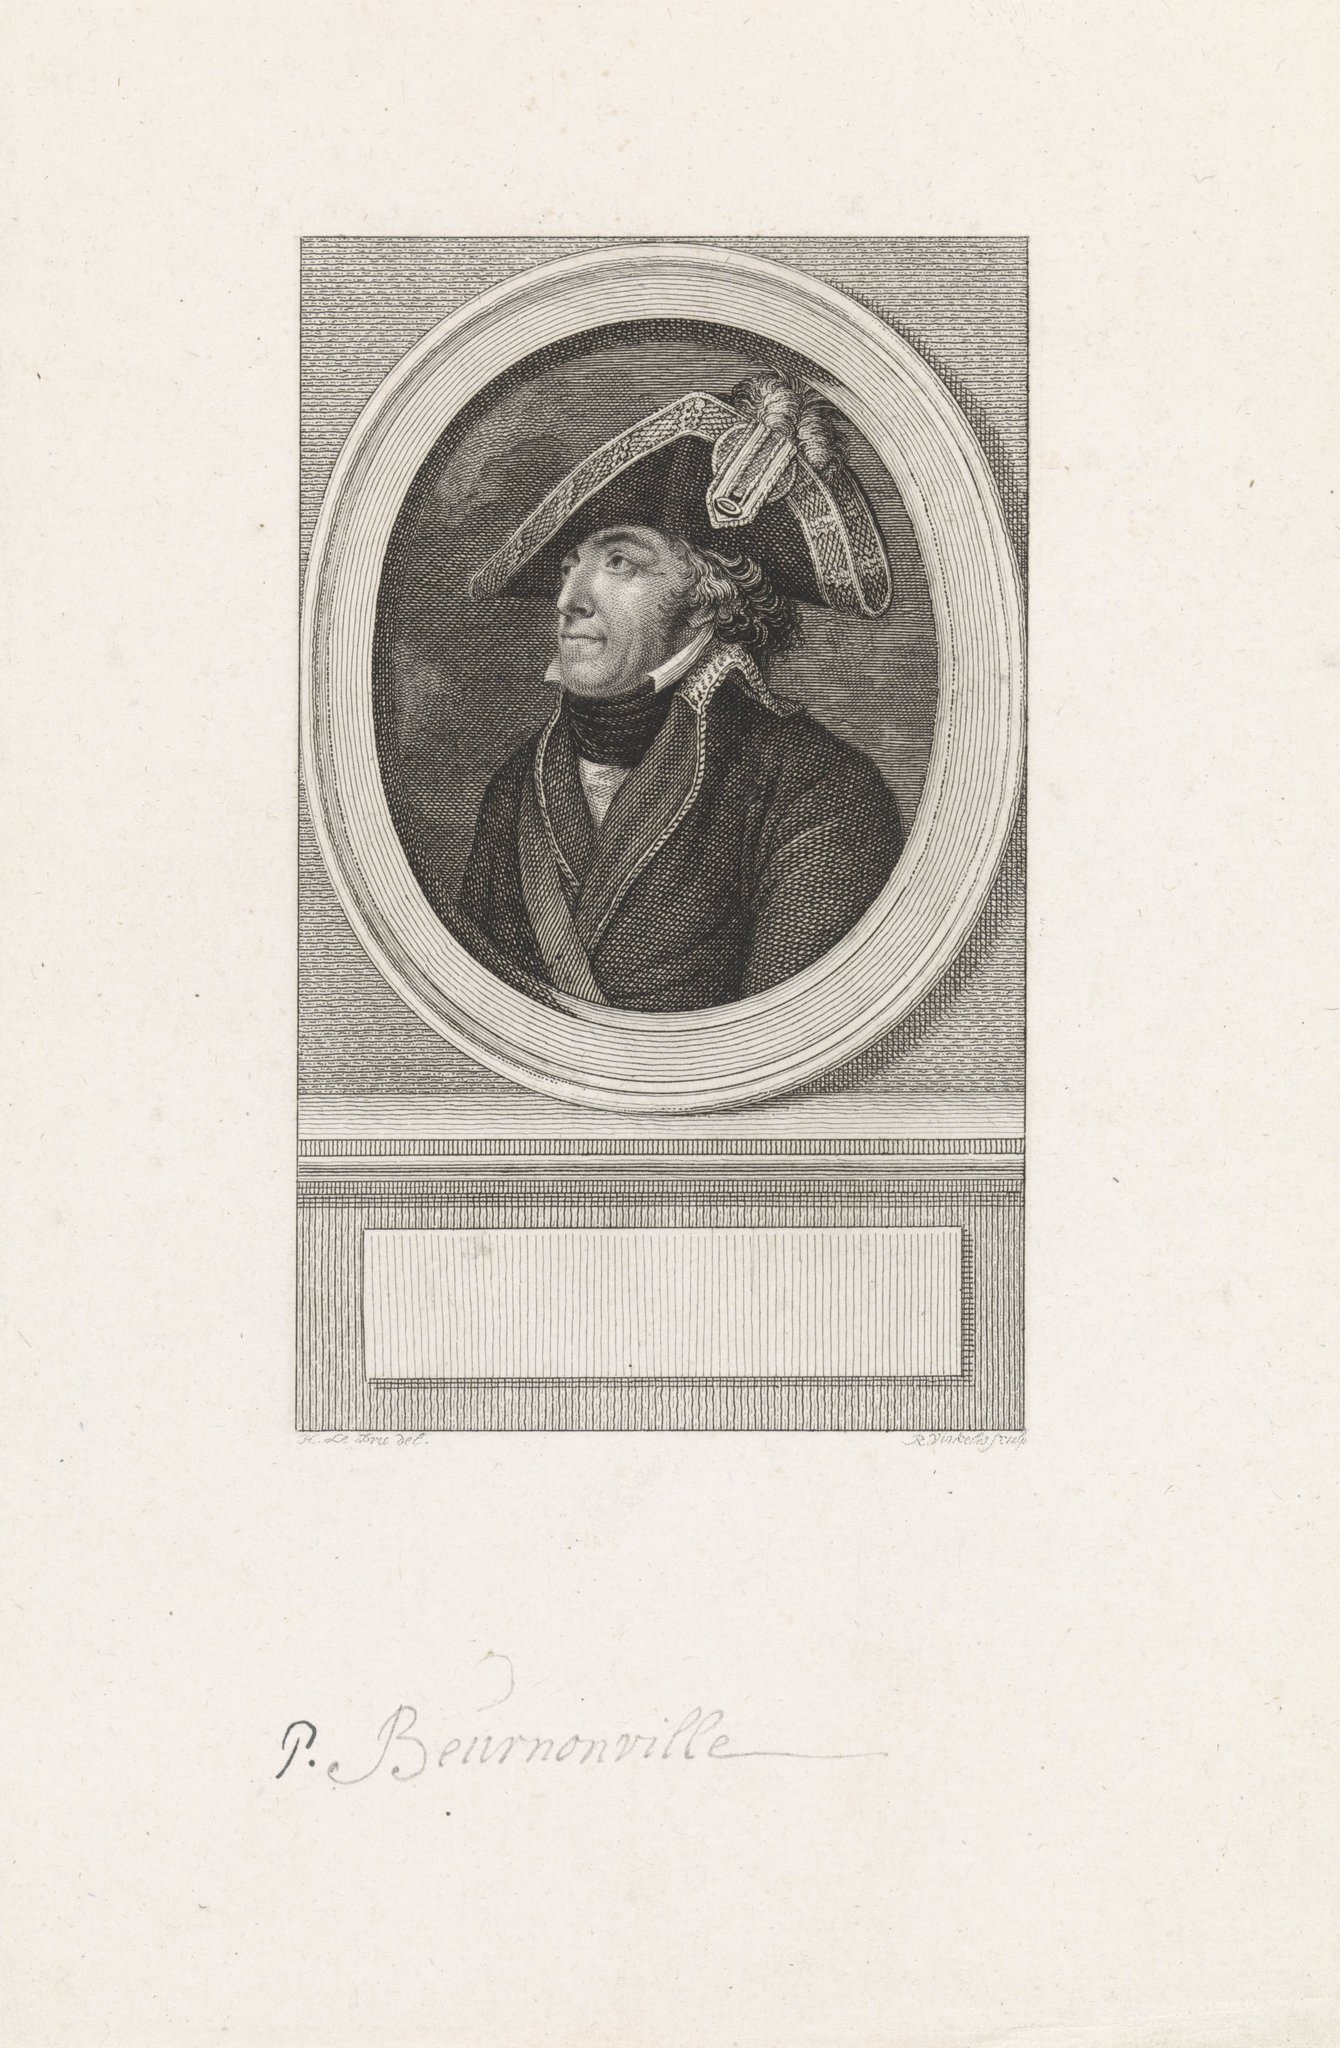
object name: print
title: Portret van Pierre de Riël de Beurnonville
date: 1793-1816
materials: paper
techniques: engraving, etching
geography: amsterdam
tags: paris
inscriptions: collector's mark: Lugt 240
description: Portret van Pierre de Riël de Beurnonville, minister van oorlog in Frankrijk.